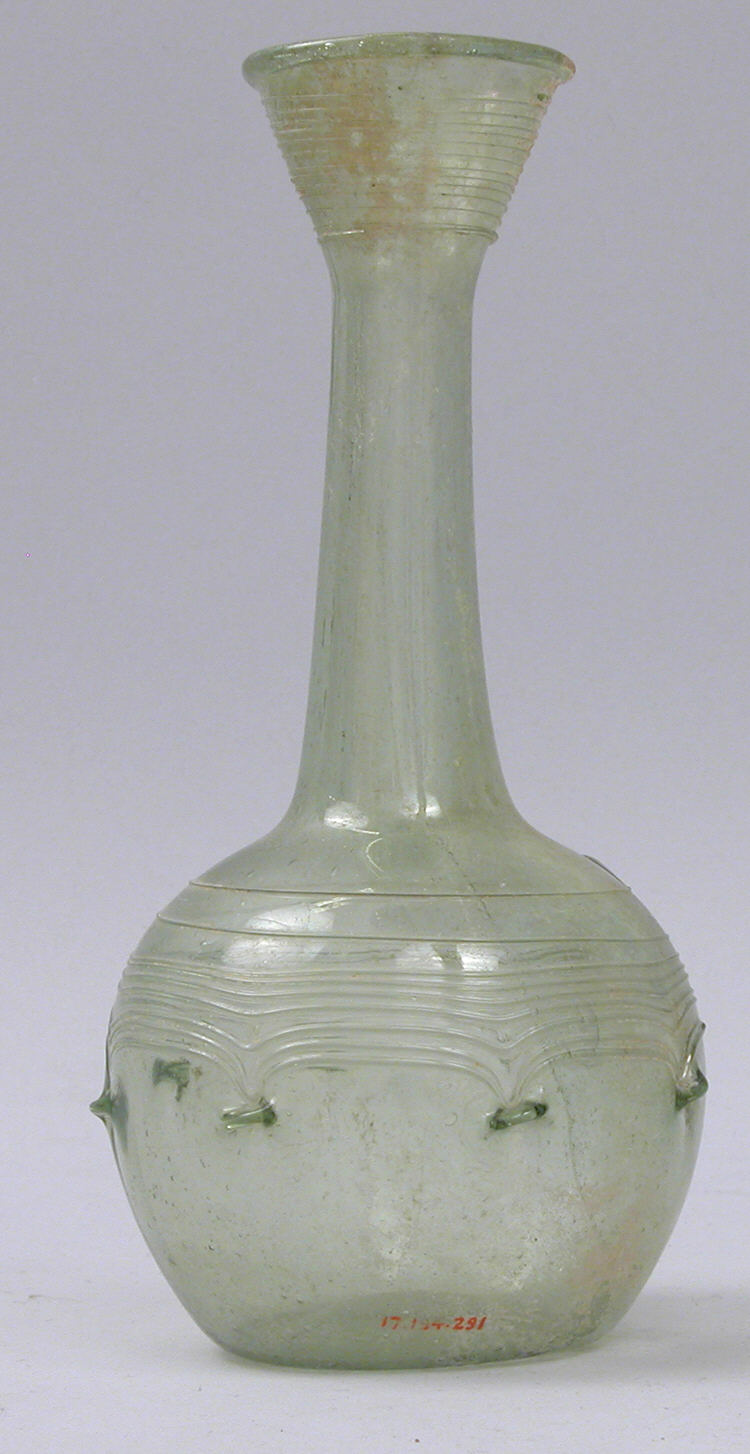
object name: bottle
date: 701-800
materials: glass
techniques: glassblowing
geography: syria